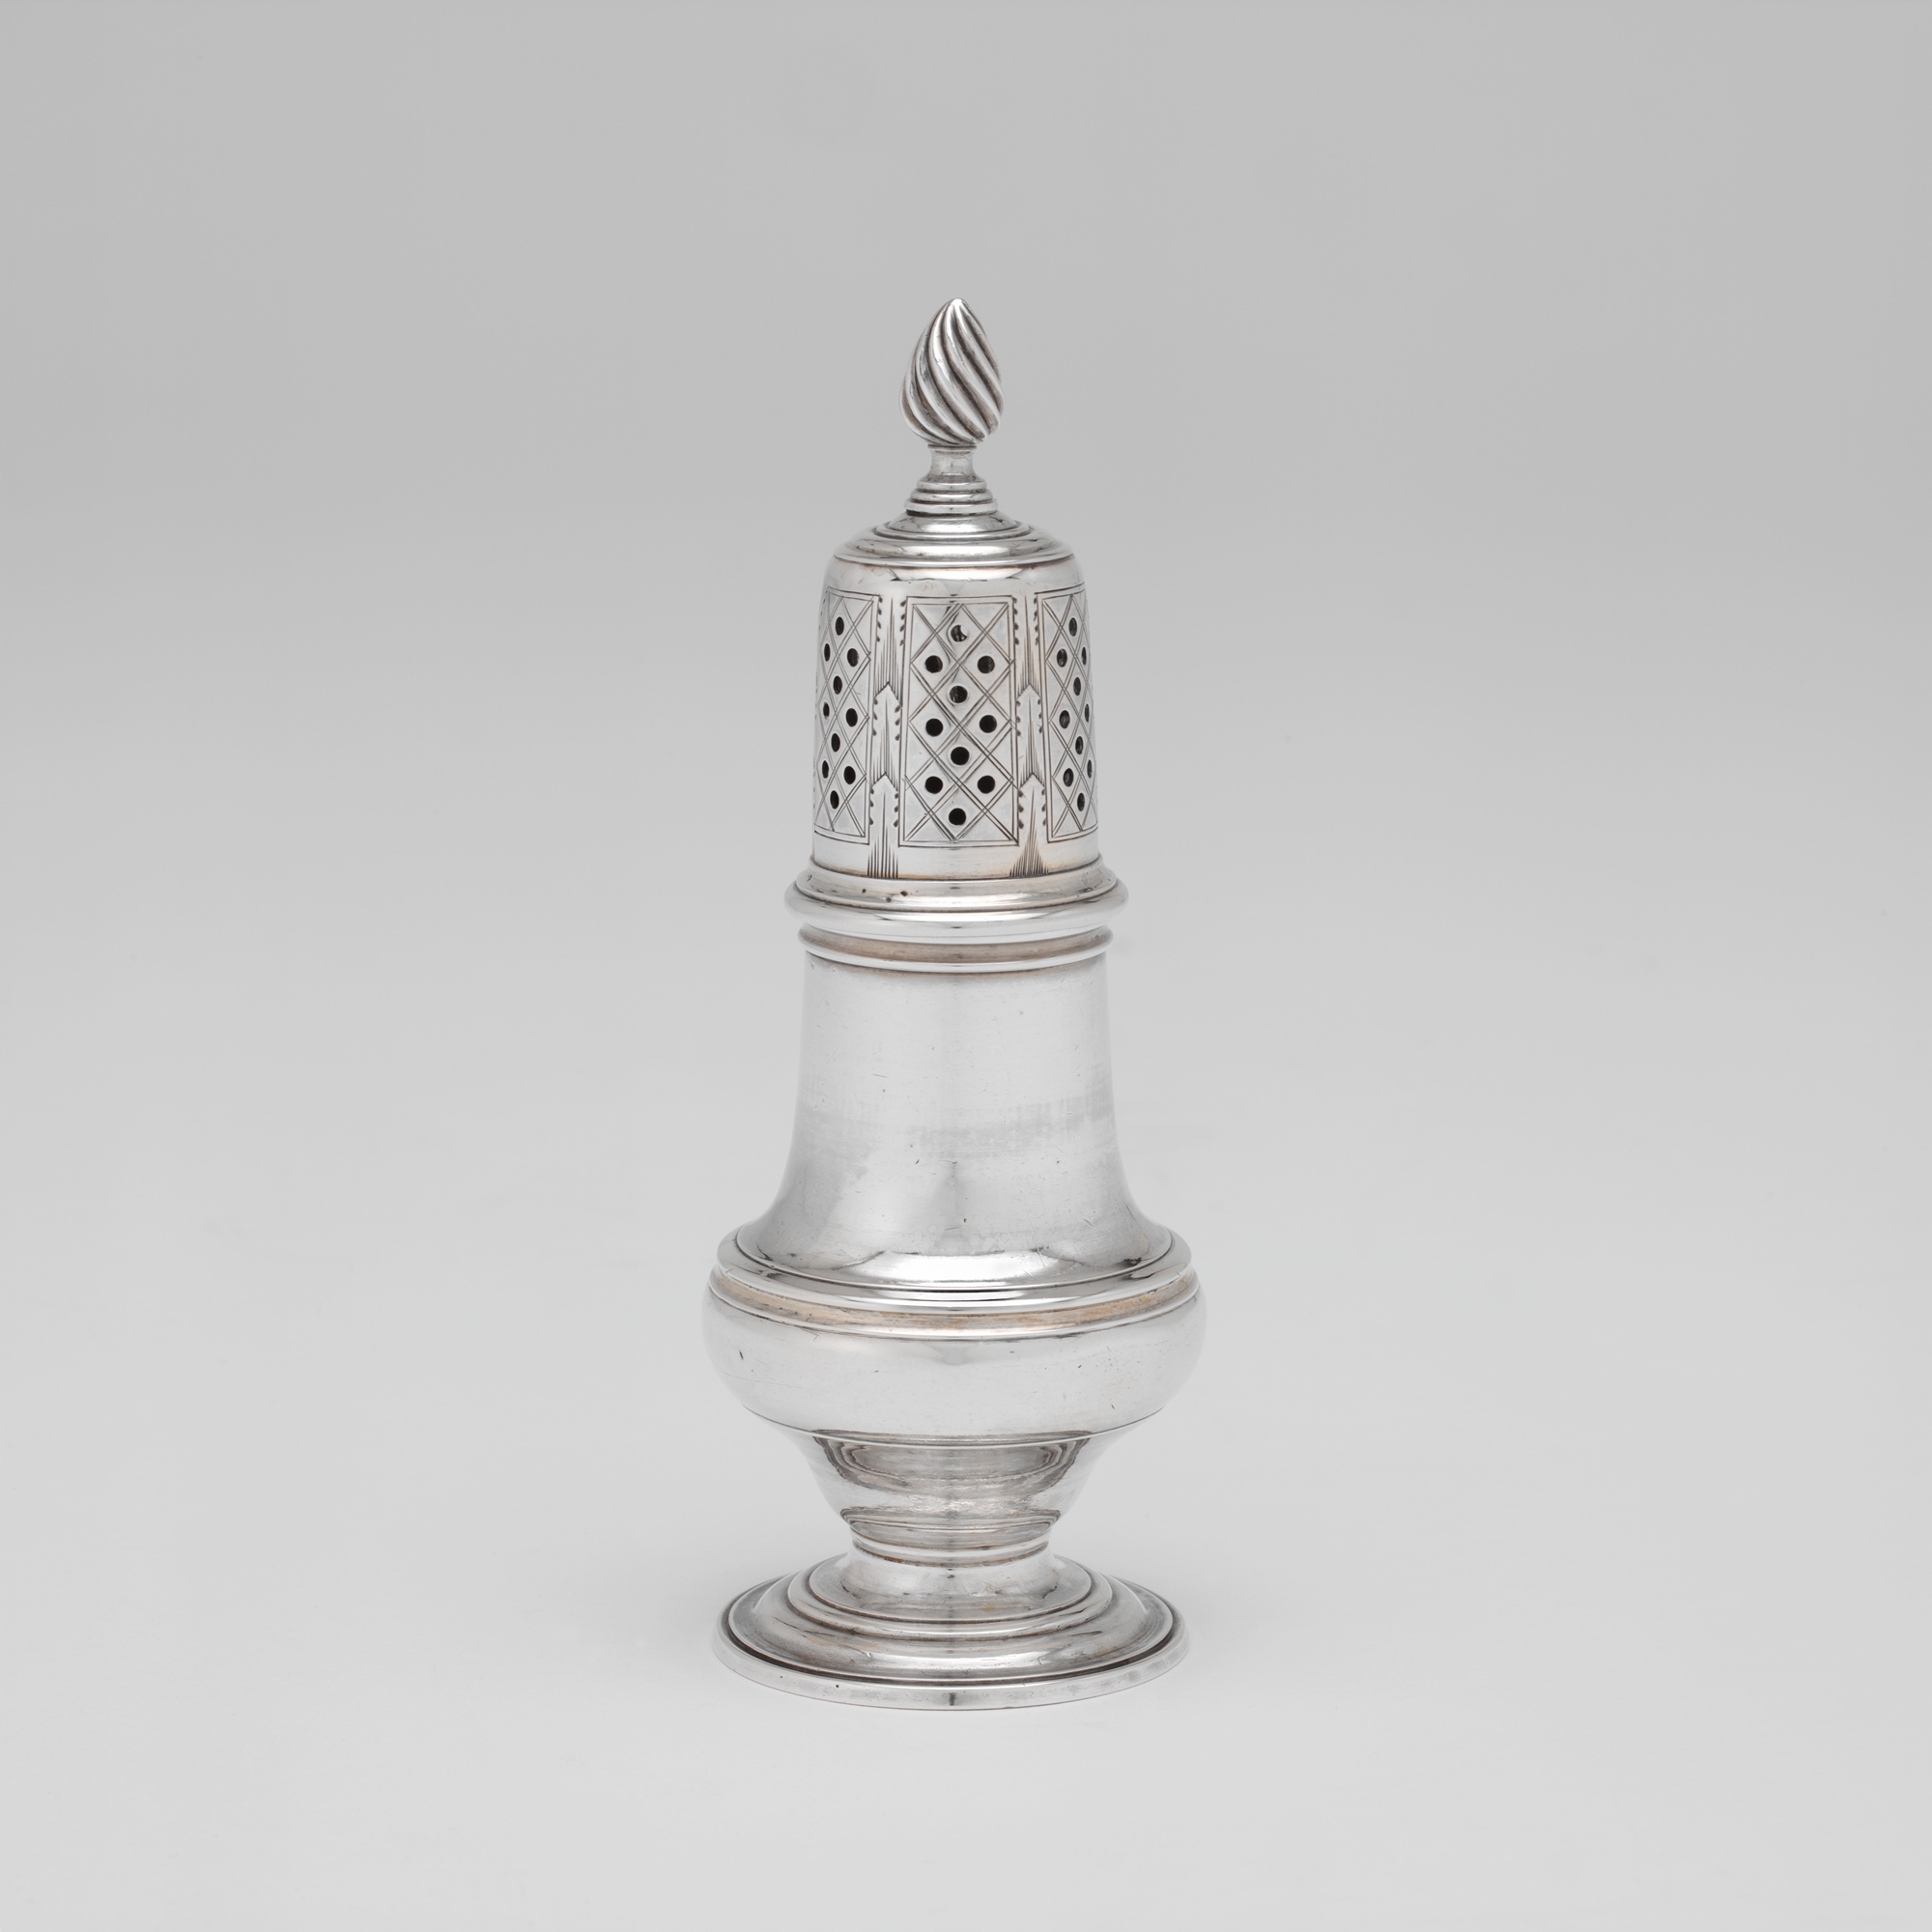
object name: caster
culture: american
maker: nathaniel helme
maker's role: maker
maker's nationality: american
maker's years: 1761-1789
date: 1780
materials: silver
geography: united states